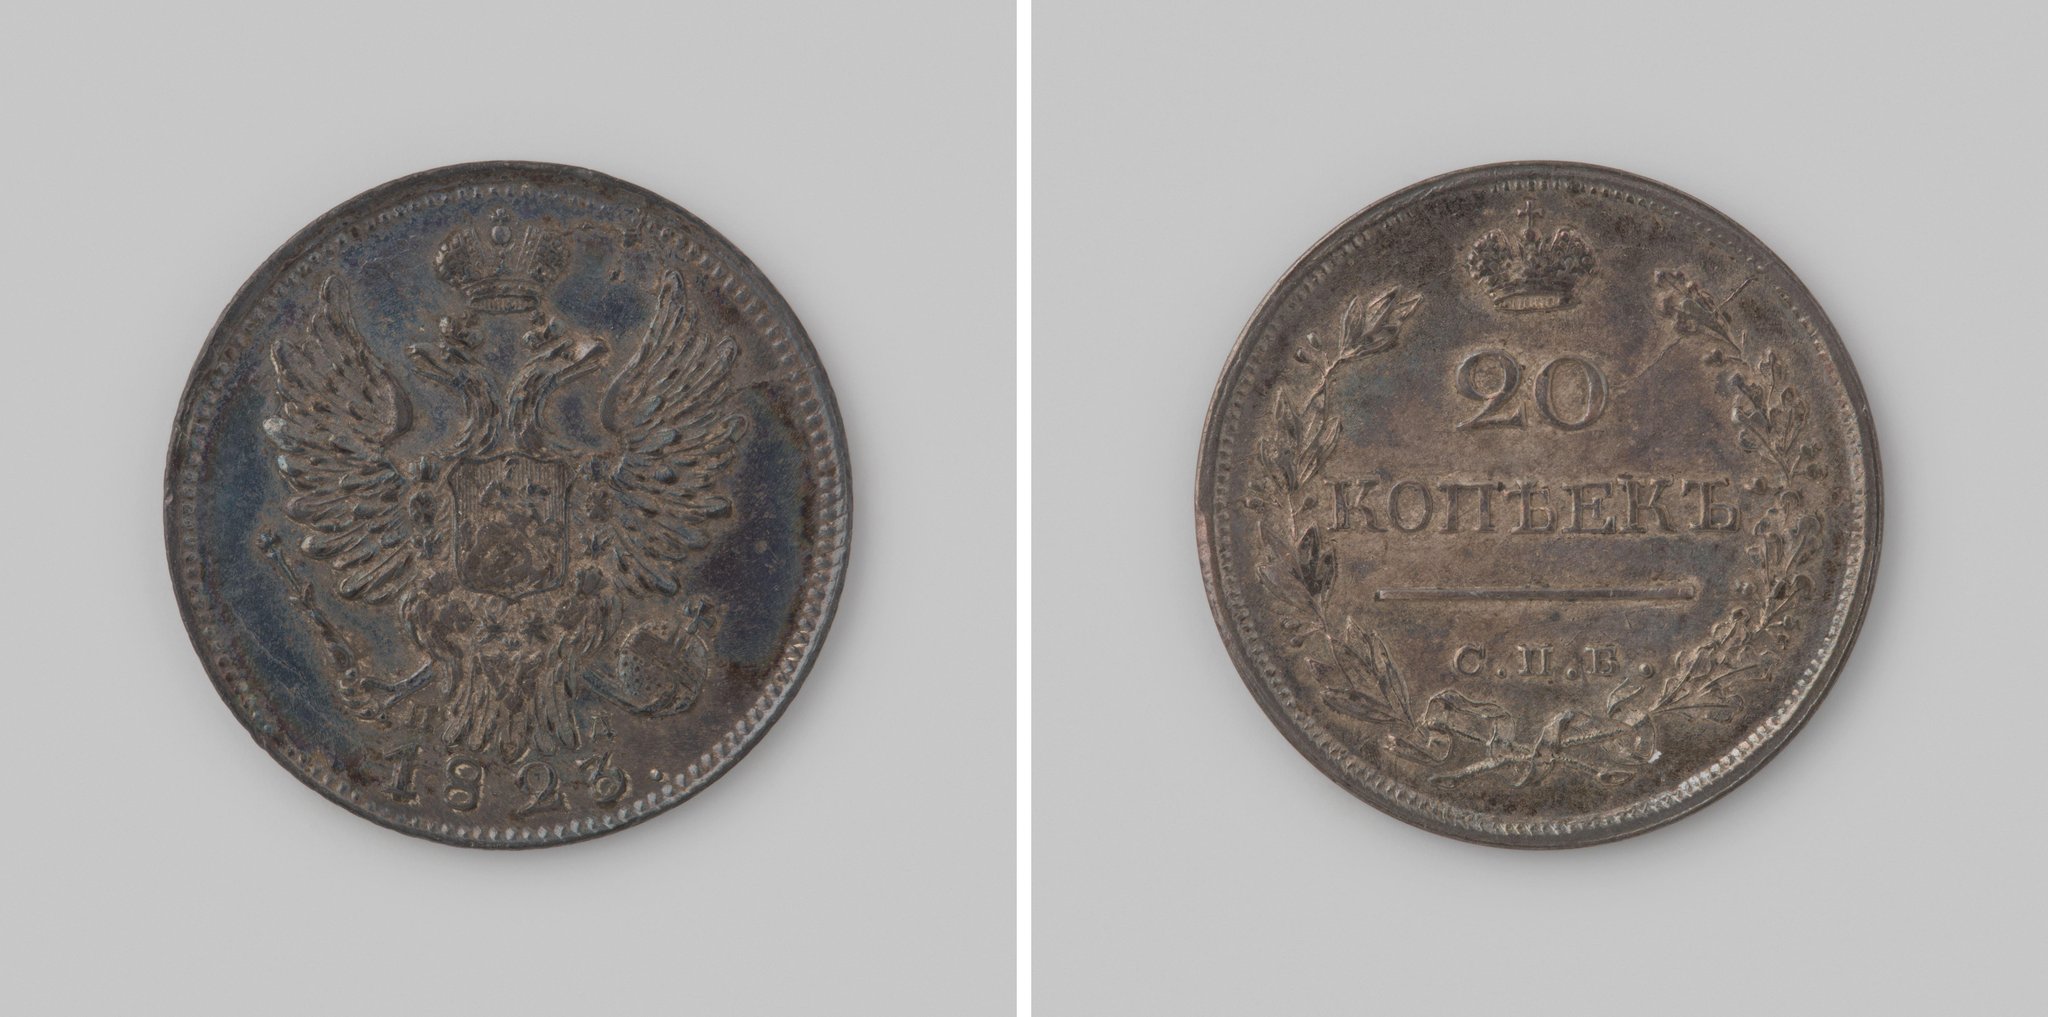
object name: coin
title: 20 kopeken uit Rusland van tsaar Alexander I, 1823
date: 1823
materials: silver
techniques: striking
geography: sint-petersburg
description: Zilveren munt. Voorzijde: dubbelkoppige gekroonde adelaar met gespreide vleugels, met op zijn borst door ridderorde omhangen wapenschild en met in zijn poten scepter en bol met daarop kruis. Boven de adelaar een kroon. Jaartal onderaan. Keerzijde: binnen twee samengebonden takken onder een kroon waarde-aanduiding in twee regels. Daaronder de letters S, P en B in Cyrillisch schrift. Kartelrand.